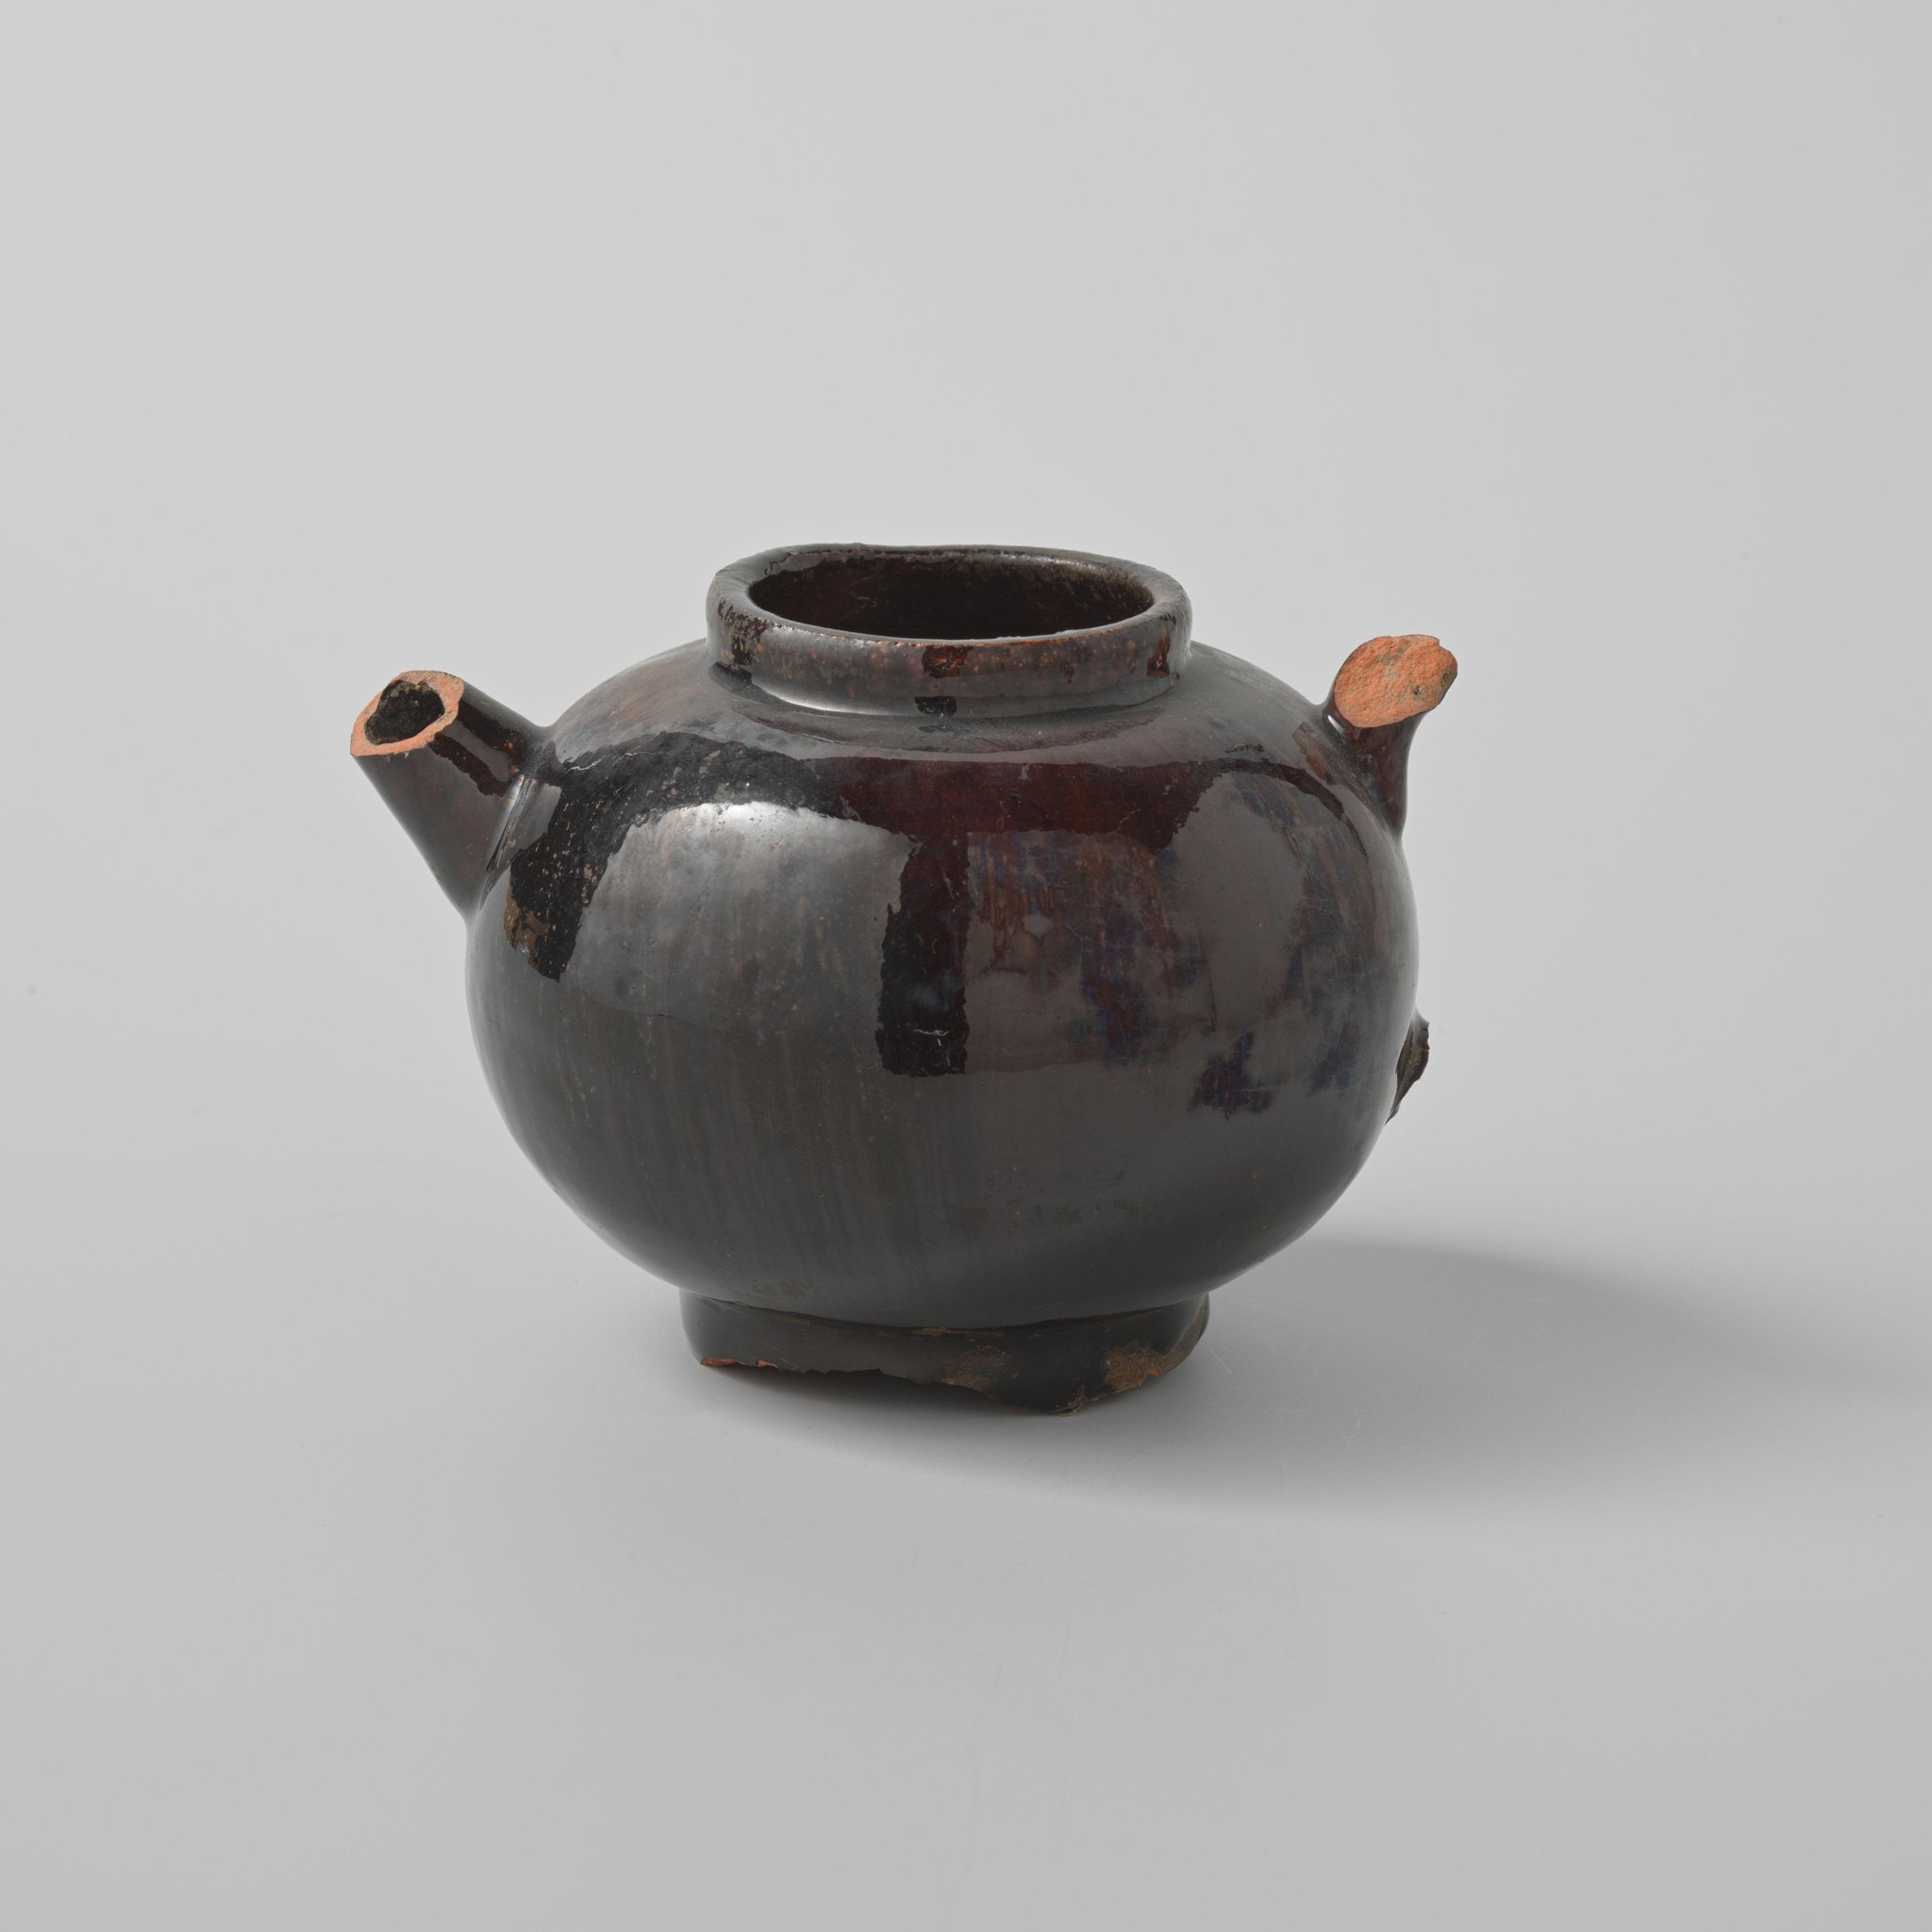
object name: fragment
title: Theepot met een zwart glazuur (De Caluwe bakafval)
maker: jacobus de caluwe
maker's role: plateelbakkerij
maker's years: -1730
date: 1700-1725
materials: earthenware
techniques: firing, vitrification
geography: delft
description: Toegeschreven aan Jacobus de Caluwe, omdat dit voorwerp samen met gemerkte stukken (‘Jacobus De Caluwe’ en rennend hert) gevonden is op de plaats waar zich De Caluwes tweede werkplaats bevond. Er is een duidelijke stilistische overeenkomst tussen de gemerkte en niet gemerkte voorwerpen uit deze archeologische vondst.